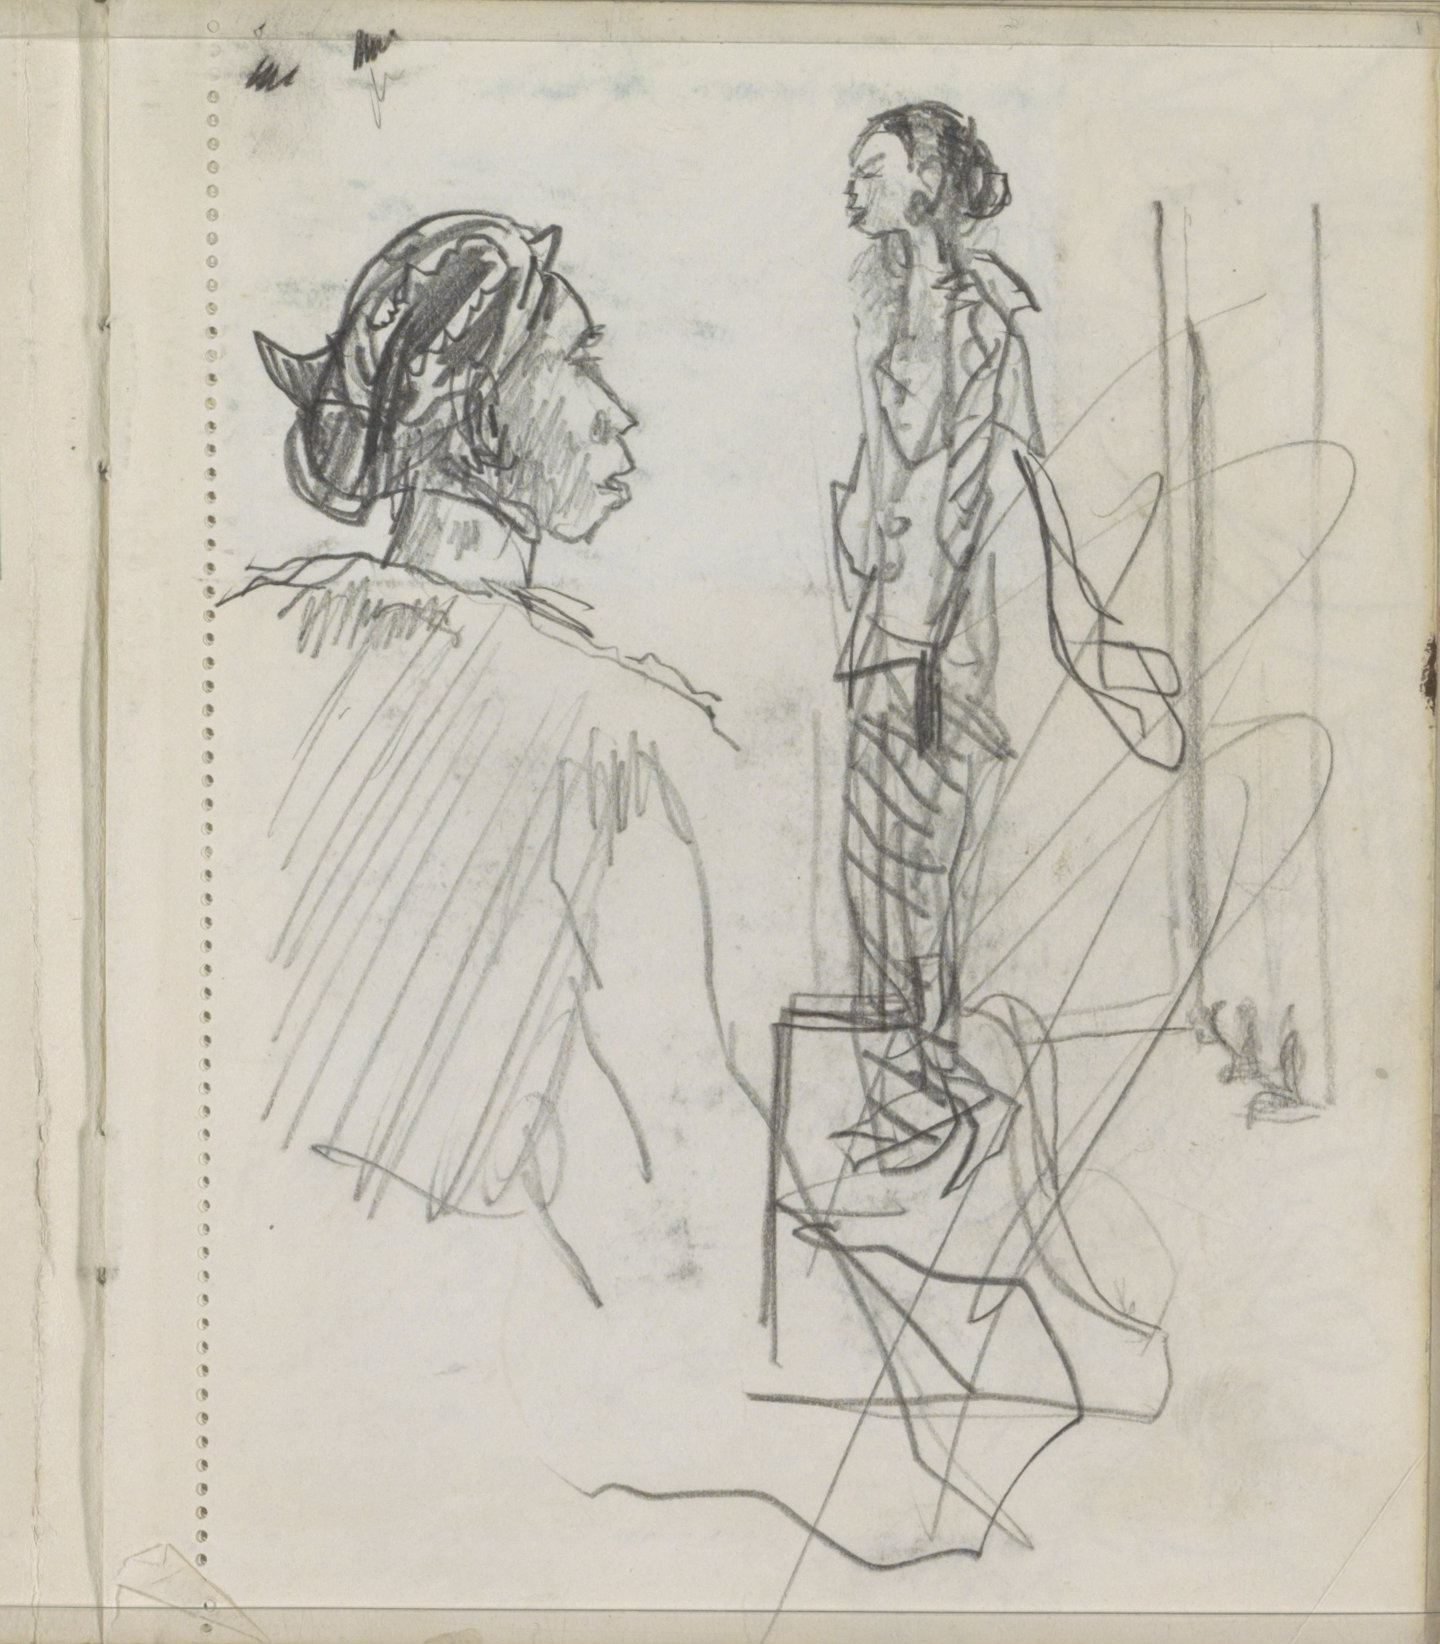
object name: sketchbook leaf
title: Indonesische vrouwen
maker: marius bauer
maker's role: draughtsman, print maker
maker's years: 1867-1932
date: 1925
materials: paper, pencil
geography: indonesia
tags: asiatic races and peoples, folk costume, regional costume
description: Pagina 1 uit een schetsboek met 67 bladen.